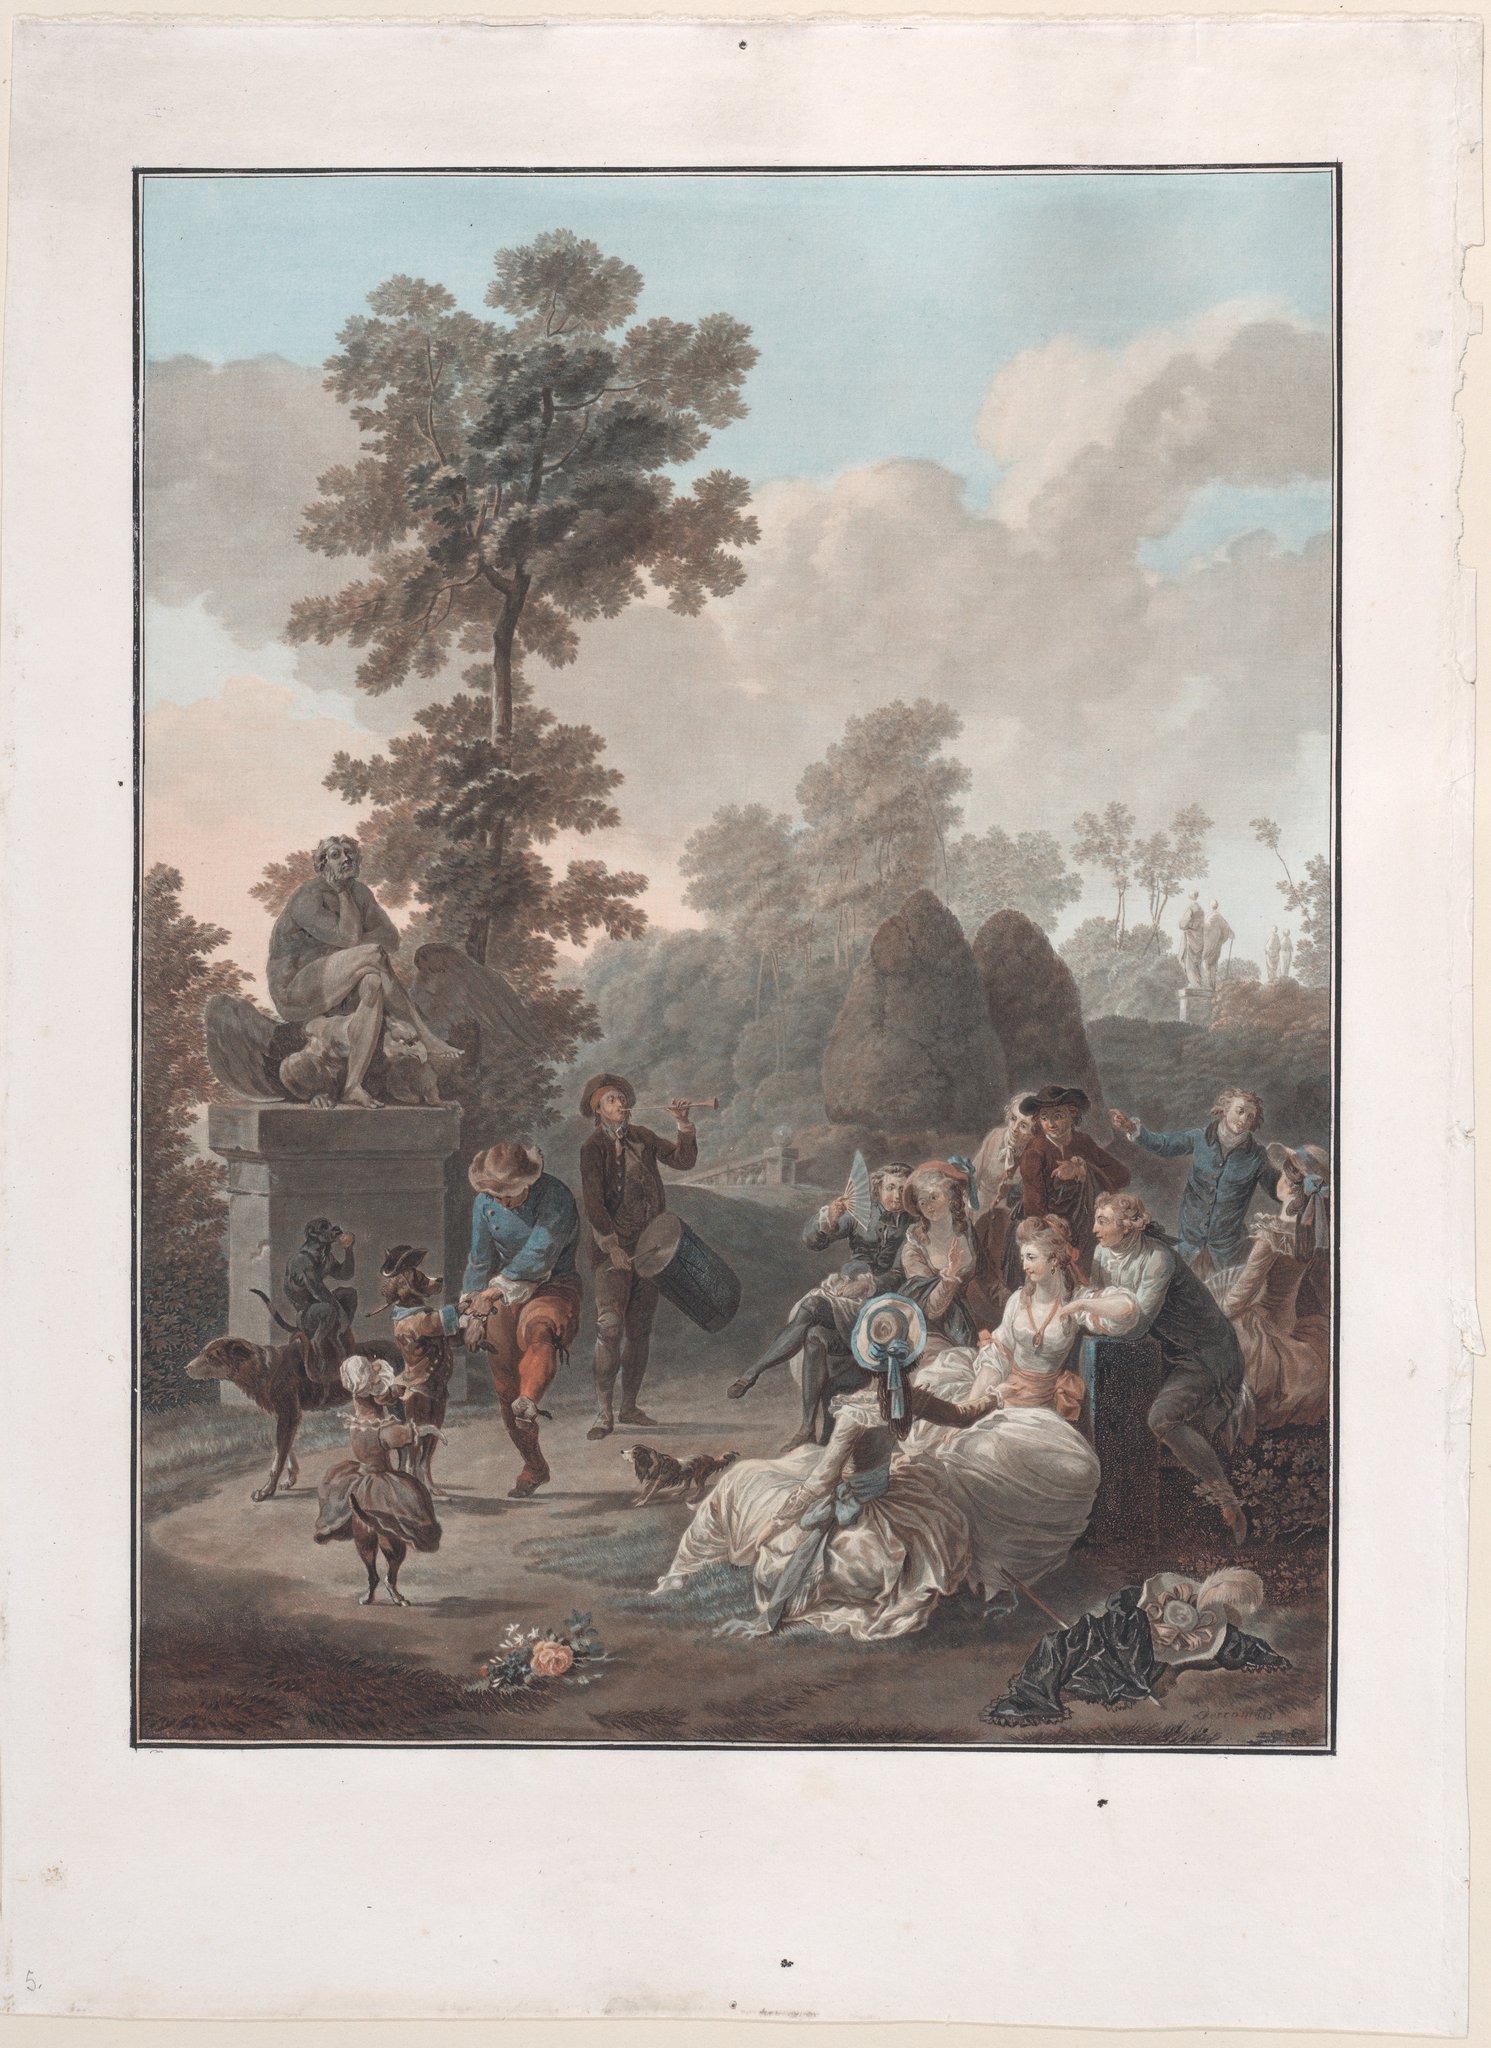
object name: print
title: Le Tambourin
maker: charles melchior descourtis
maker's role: artist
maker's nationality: french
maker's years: 1753-1820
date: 1788-1794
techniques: aquatint, engraving, etching